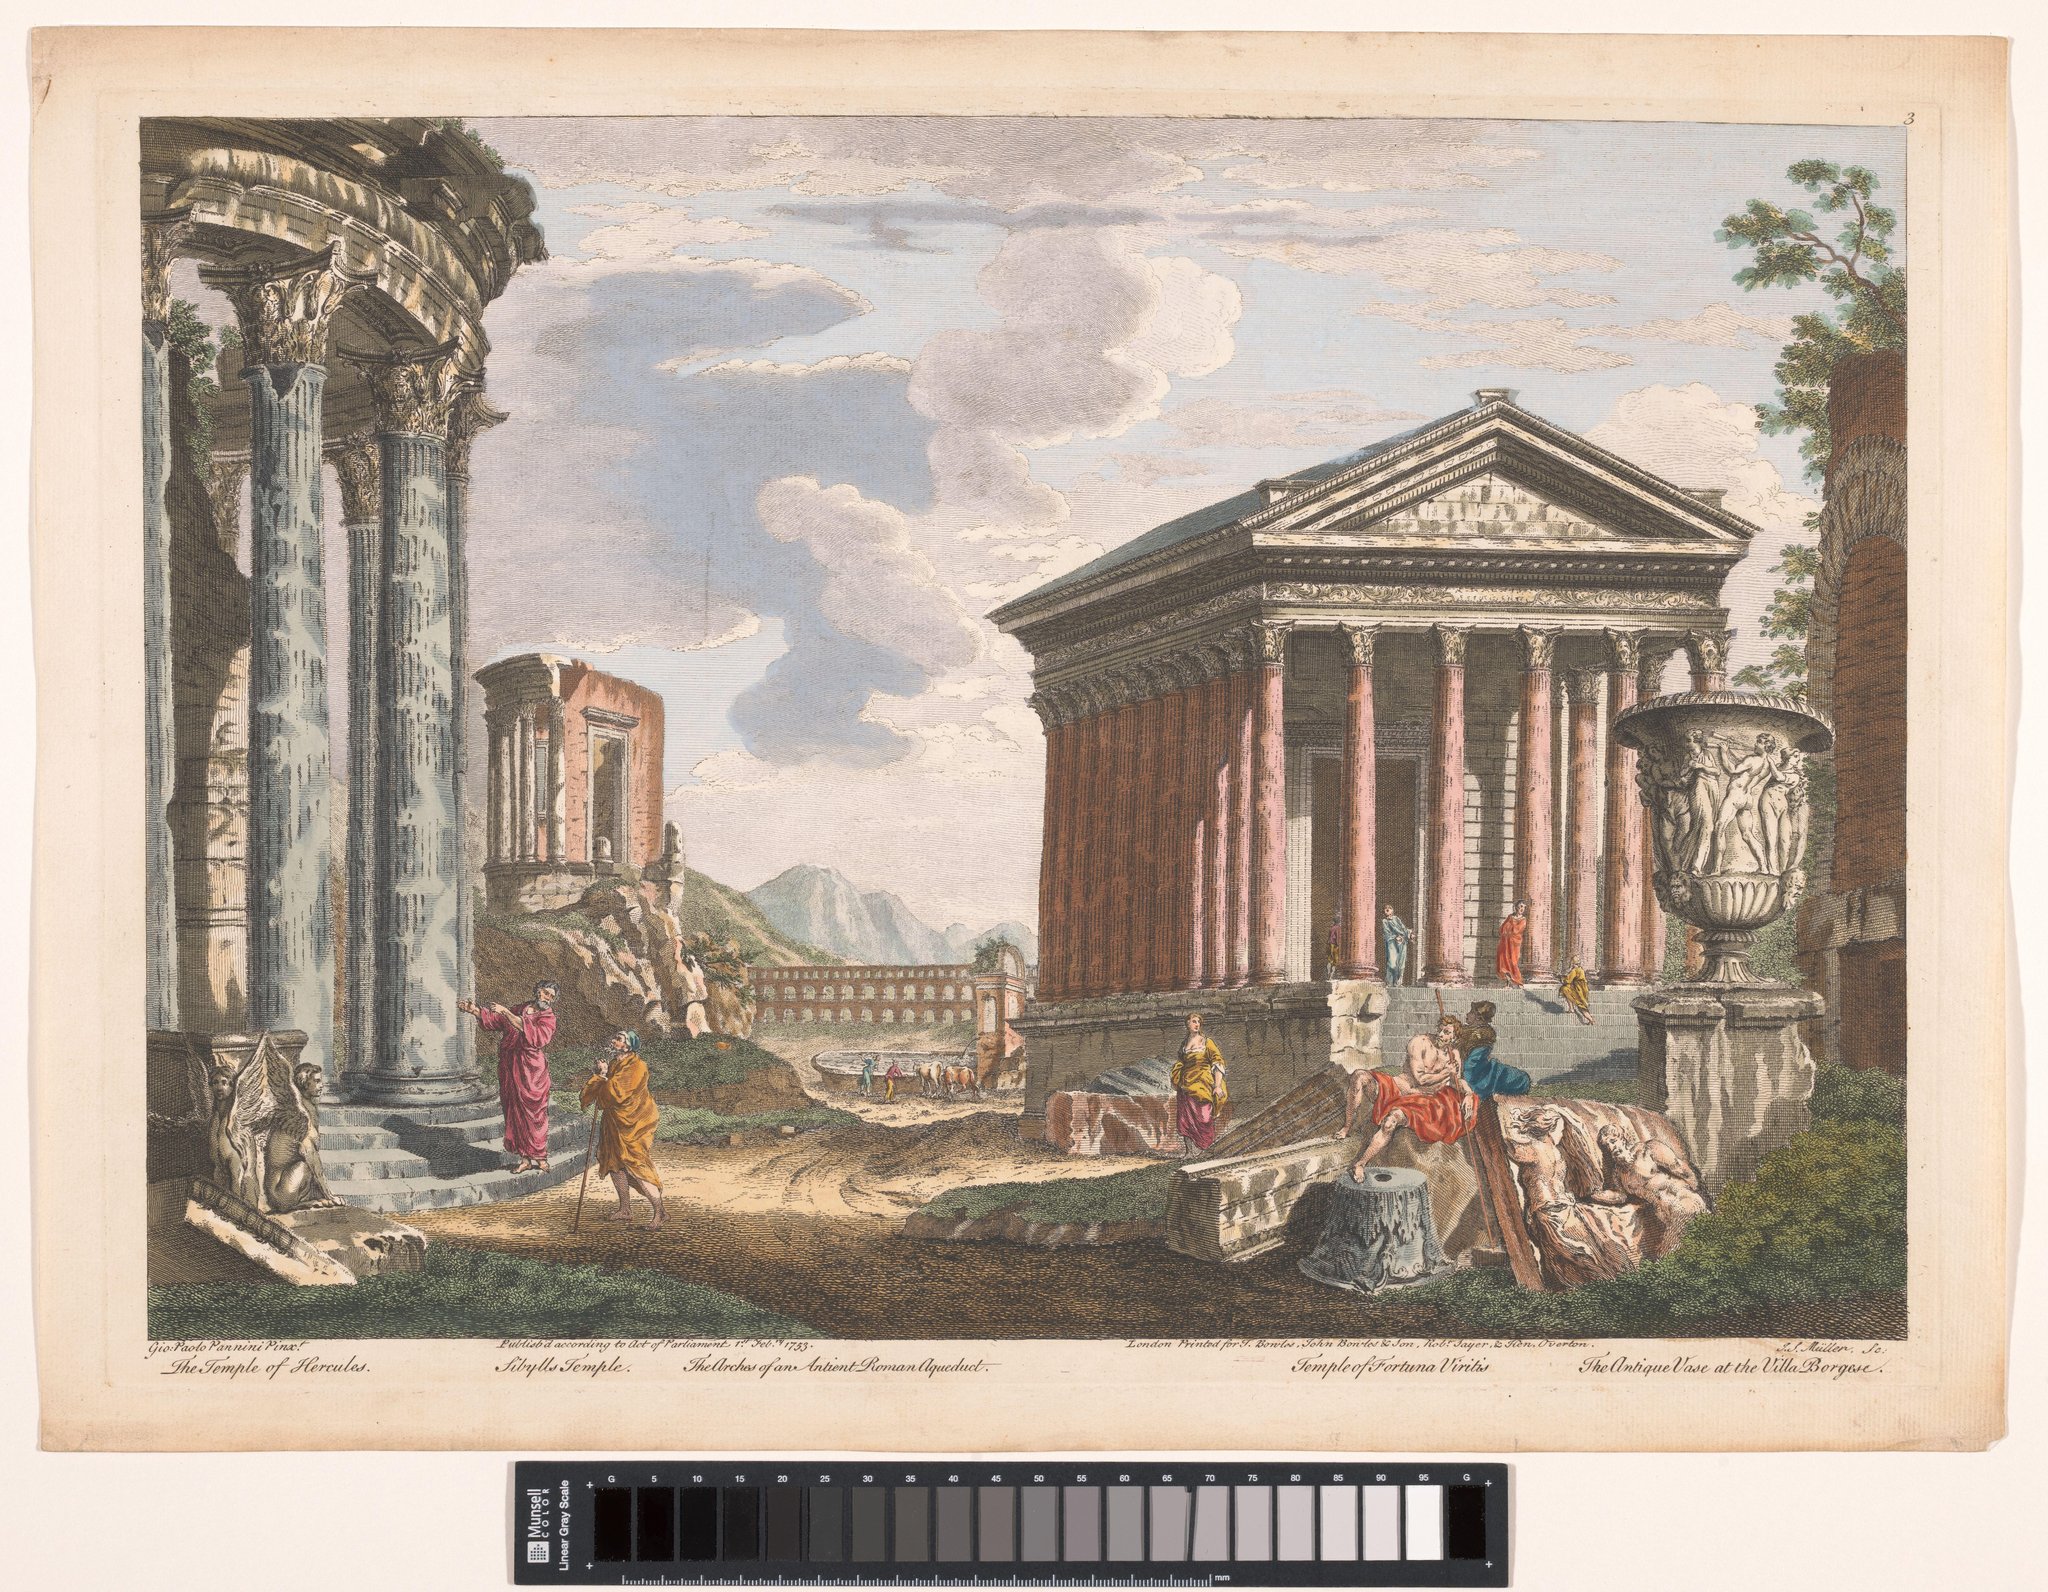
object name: print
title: Romeinse oudheid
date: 1753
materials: paper, watercolor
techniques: brush, etching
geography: london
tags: aqueduct (~ water supply), temple, shrine ~ roman religion, container of stone: stone vase, landscape with ruins (+ city(-scape) with figures, staffage)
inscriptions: watermark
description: Bij de brokstukken staan en zitten figuren. In de ondermarge regels Engelse tekst. Rechtsboven genummerd: 3.